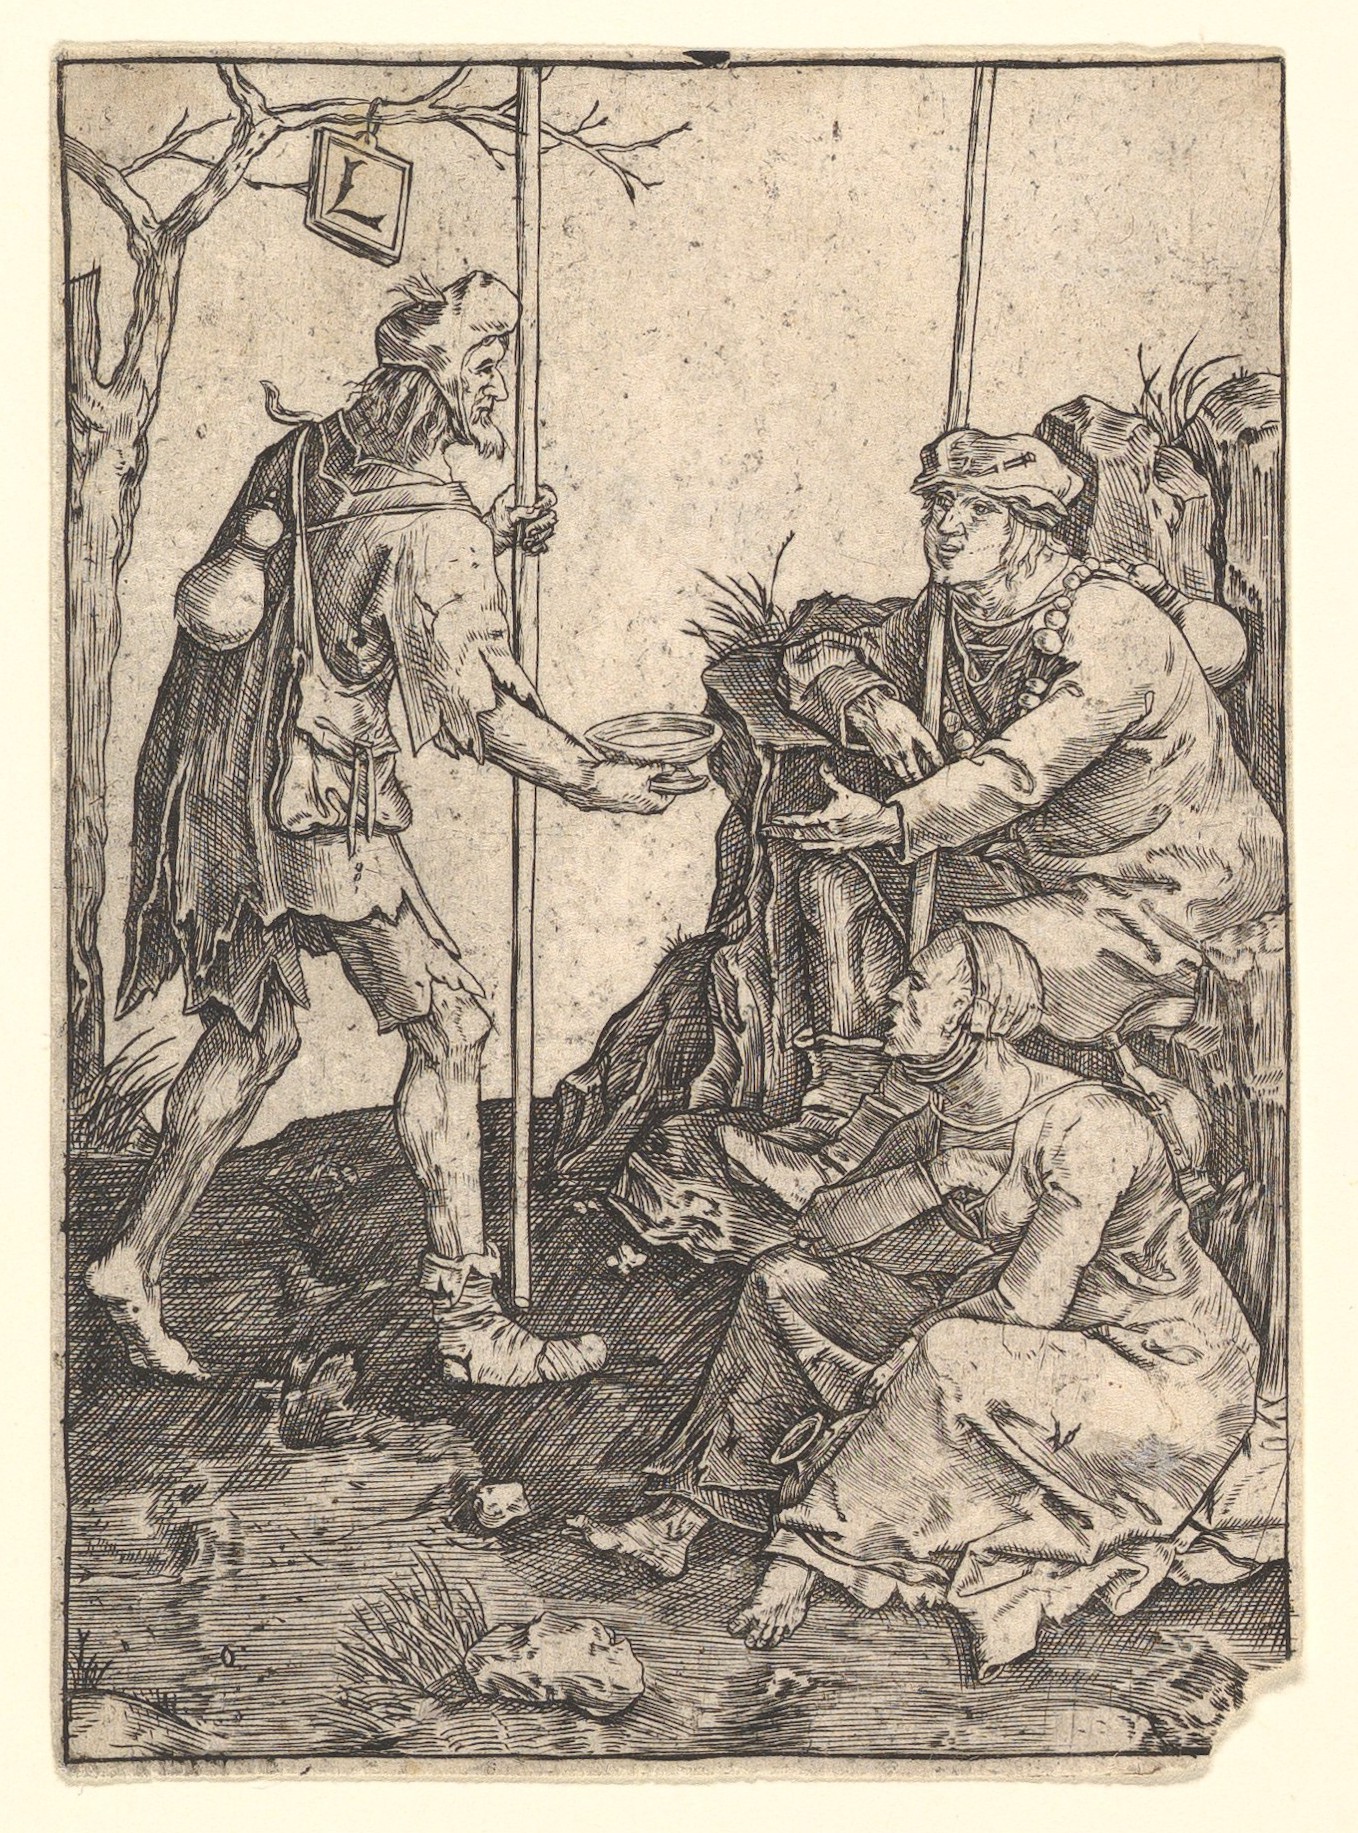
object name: print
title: The Beggars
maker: lucas van leyden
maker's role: artist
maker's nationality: netherlandish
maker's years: 1494-1533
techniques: engraving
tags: men